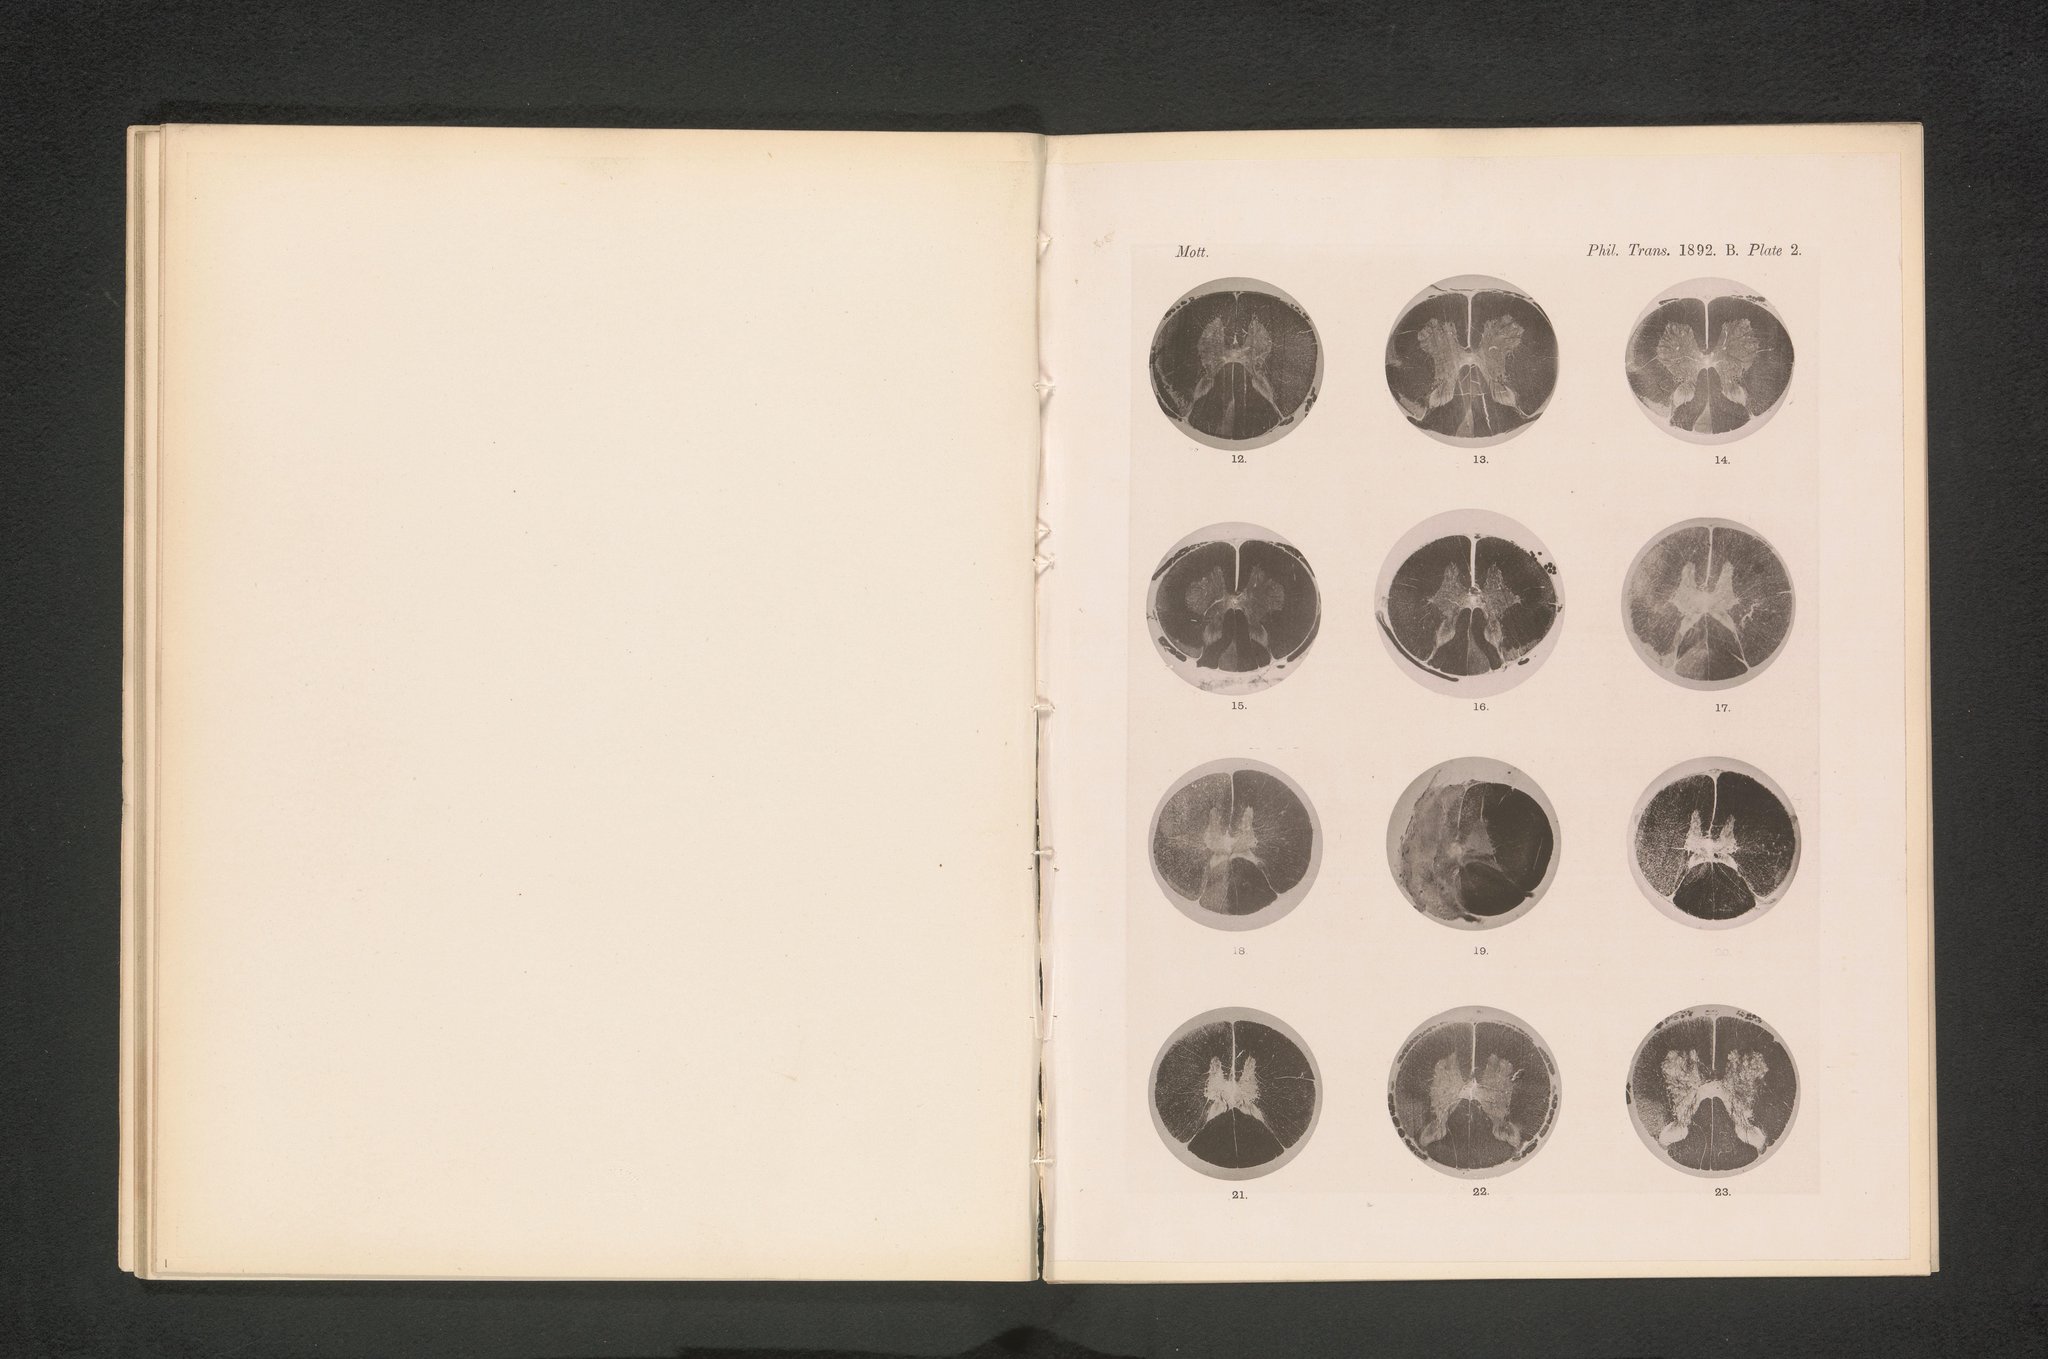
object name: page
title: Twaalf doorsneden van beschadigde ruggengraten van apen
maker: Anonymous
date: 1887-1892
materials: paper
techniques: photograph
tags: dissection, spine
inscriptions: check stamp: ‘THE UNIVERSITY/ LI[VER]POOL’, inscription: ‘Mott. Phil. Trans. 1892. B. Plate 2.’, number: ‘12. (...) 23.’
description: Prenten op vierde ongenummerde pagina na pagina 59.